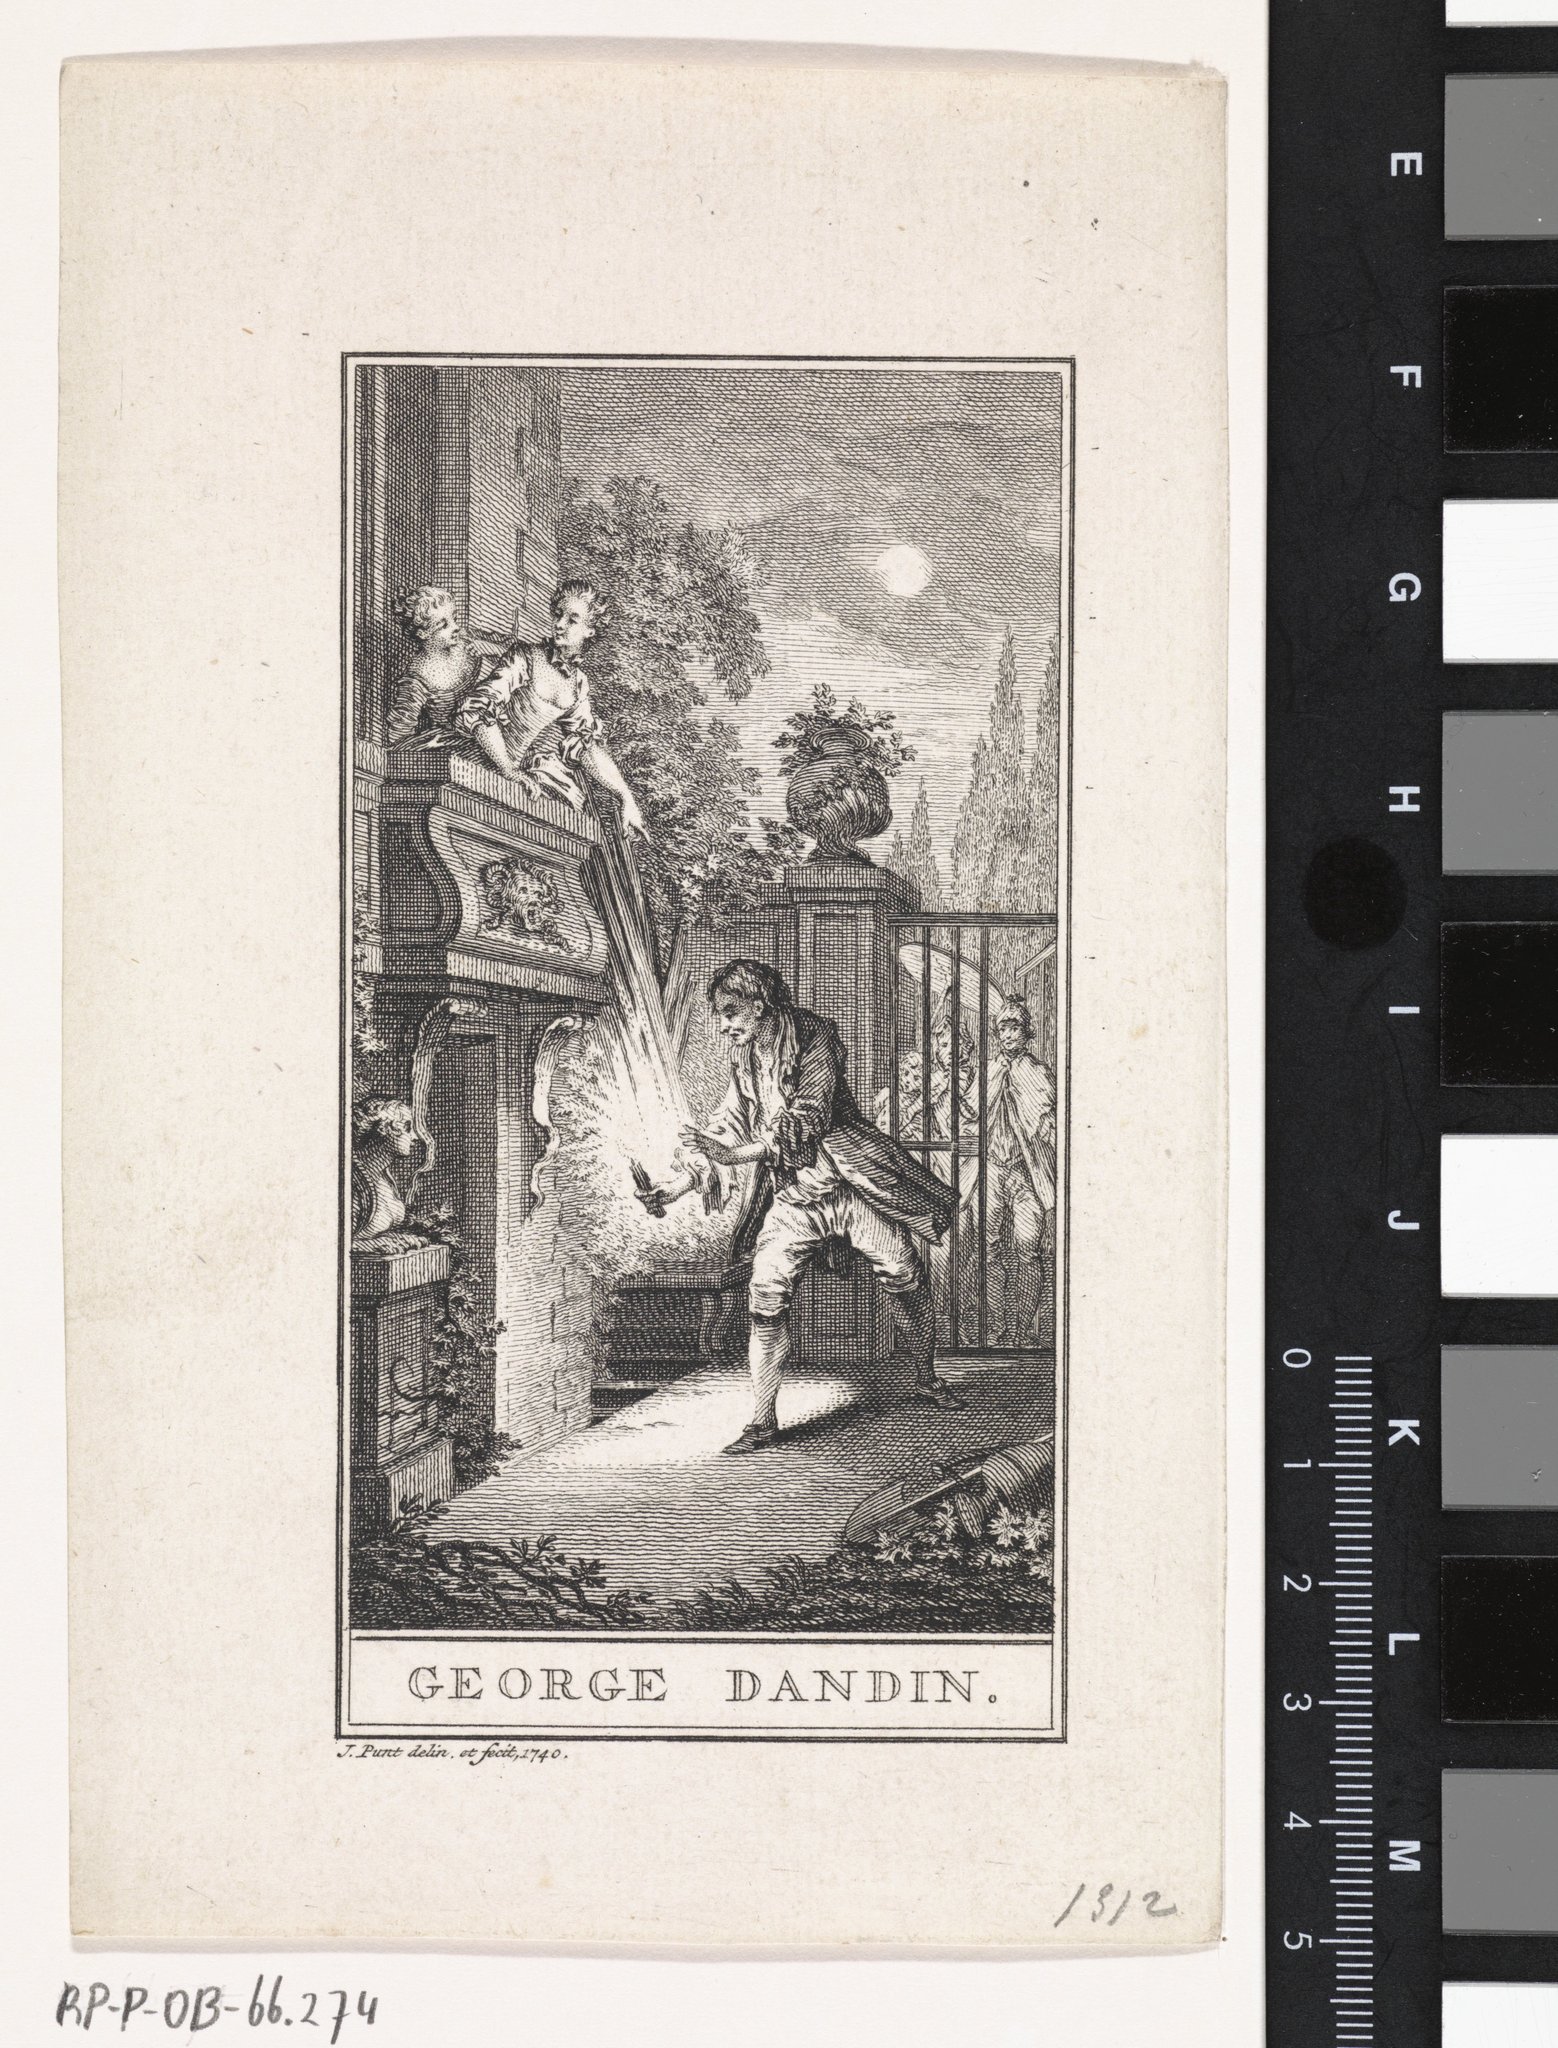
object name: print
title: Man met kaars onder balkon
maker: jan punt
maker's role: draughtsman, print maker, publisher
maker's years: 1711-1779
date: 1740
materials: paper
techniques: engraving, etching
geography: amsterdam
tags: (moliere) specific works of literature (with author, title), balcony, night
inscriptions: collector's mark: Lugt 2228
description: Een man staat met een brandende kaars in de nacht onder een balkon in een tuin. Op het balkon twee vrouwen. Achter het tuinhek kijkt een gezelschap toe. Scène uit het toneelstuk George Dandin ou le Mari confondu, van Molière.